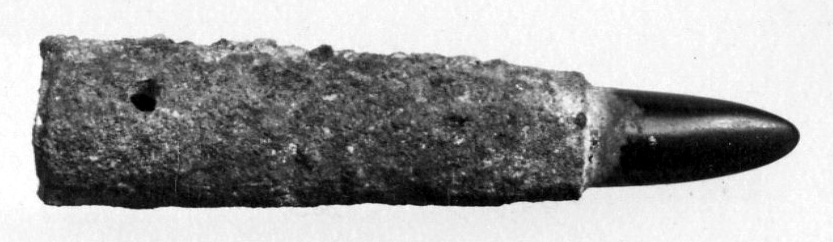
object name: burnishing tool, goldsmith's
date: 1-400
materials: bone, bronze, copper alloy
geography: upper egypt, thebes